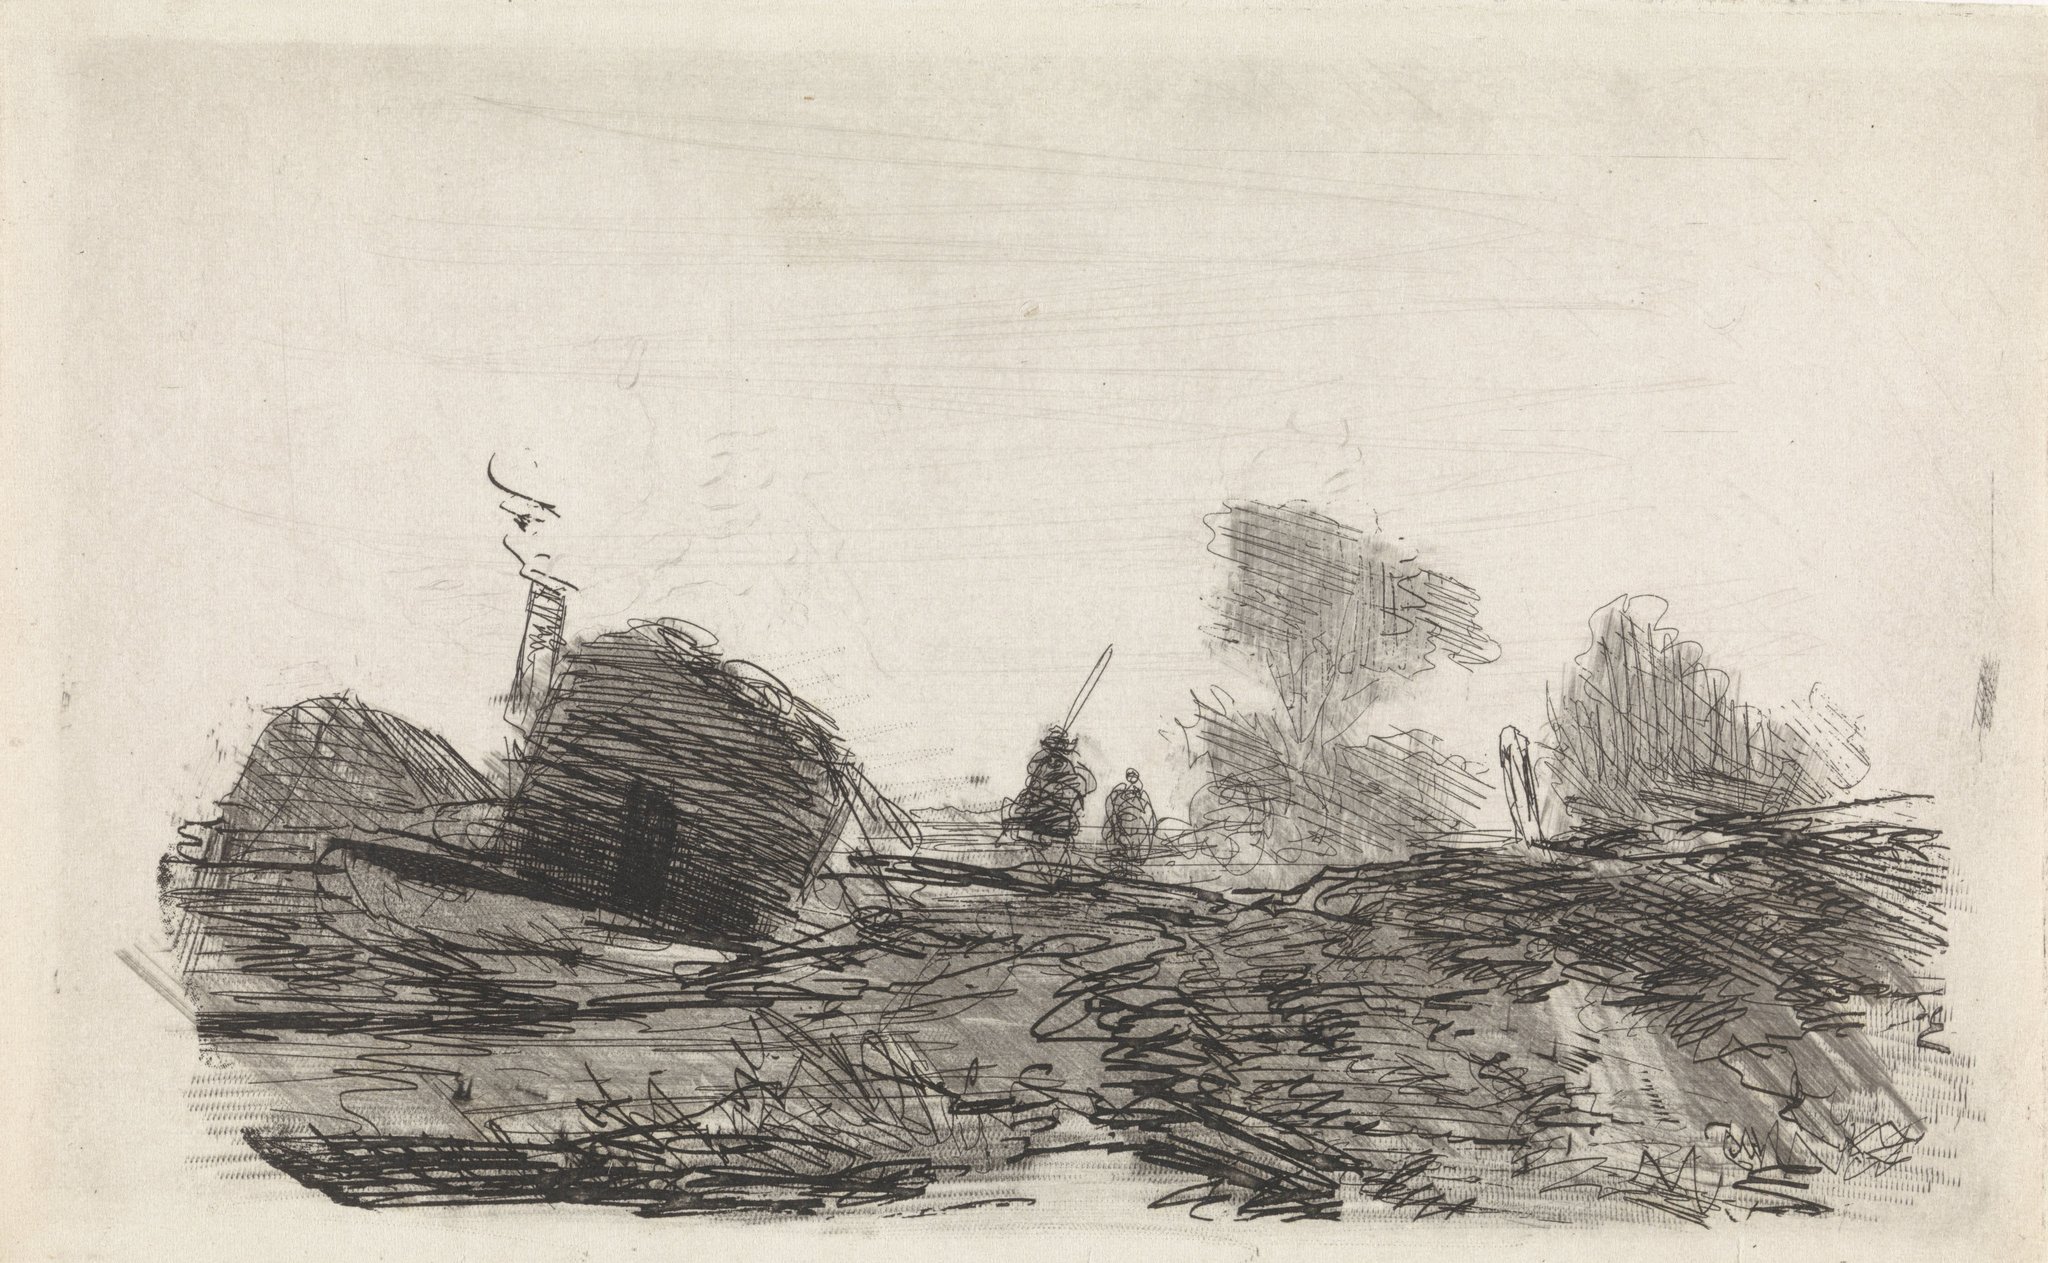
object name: print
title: Landschap met een schuur en twee ruiters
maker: johannes franciscus hoppenbrouwers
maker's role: draughtsman, painter, print maker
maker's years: 1819-1866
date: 1829-1866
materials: paper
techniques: etching, roulette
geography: the hague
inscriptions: collector's mark: Lugt 2228, inscription: ‘enigste druk’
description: Landschap met een schuur met een rokende schoorsteen. In het midden twee ruiters, waarvan een een stok over de schouder heeft.